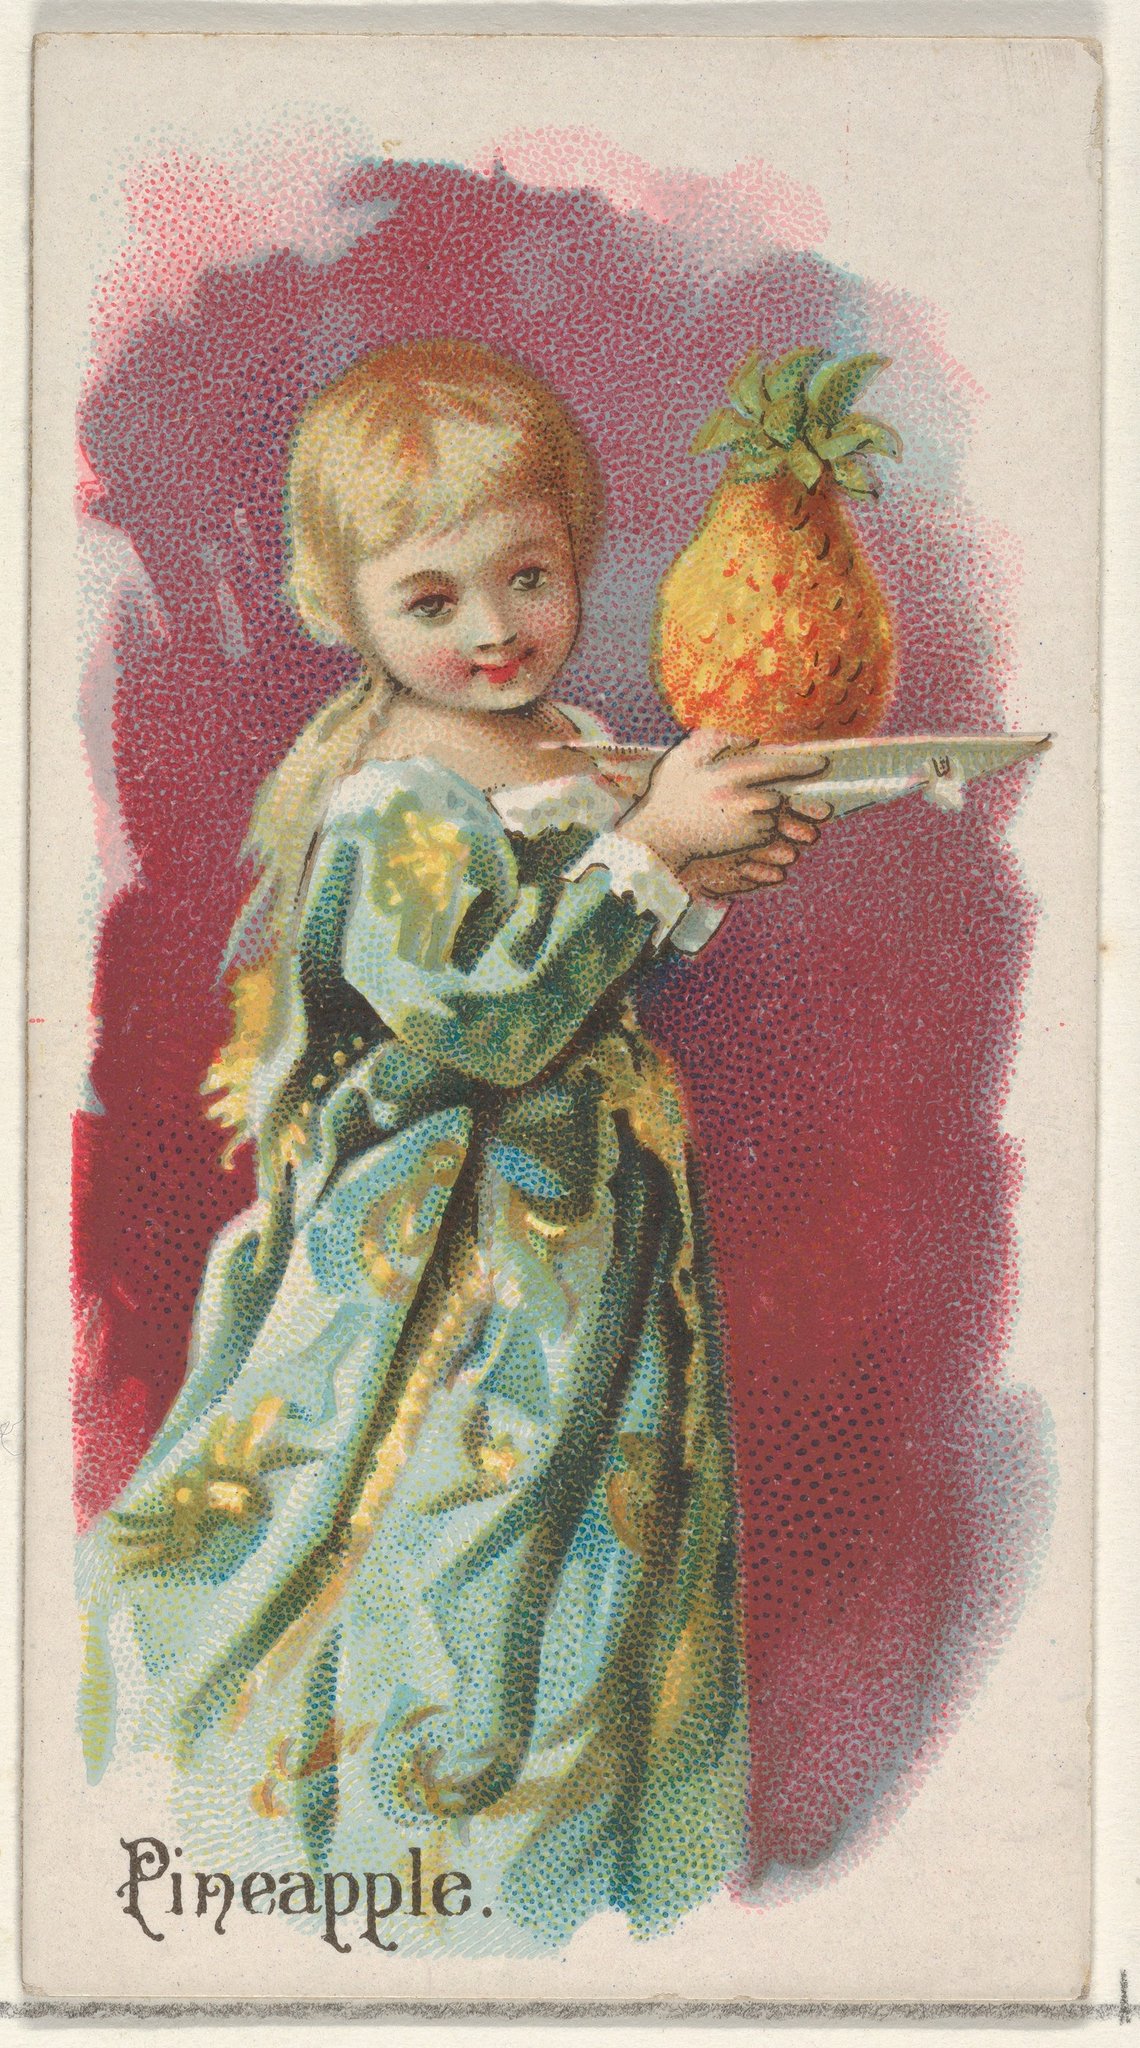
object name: print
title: Pineapple, from the Fruits series (N12) for Allen & Ginter Cigarettes Brands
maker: allen & ginter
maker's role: publisher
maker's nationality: american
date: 1891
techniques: color lithograph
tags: fruit,girls